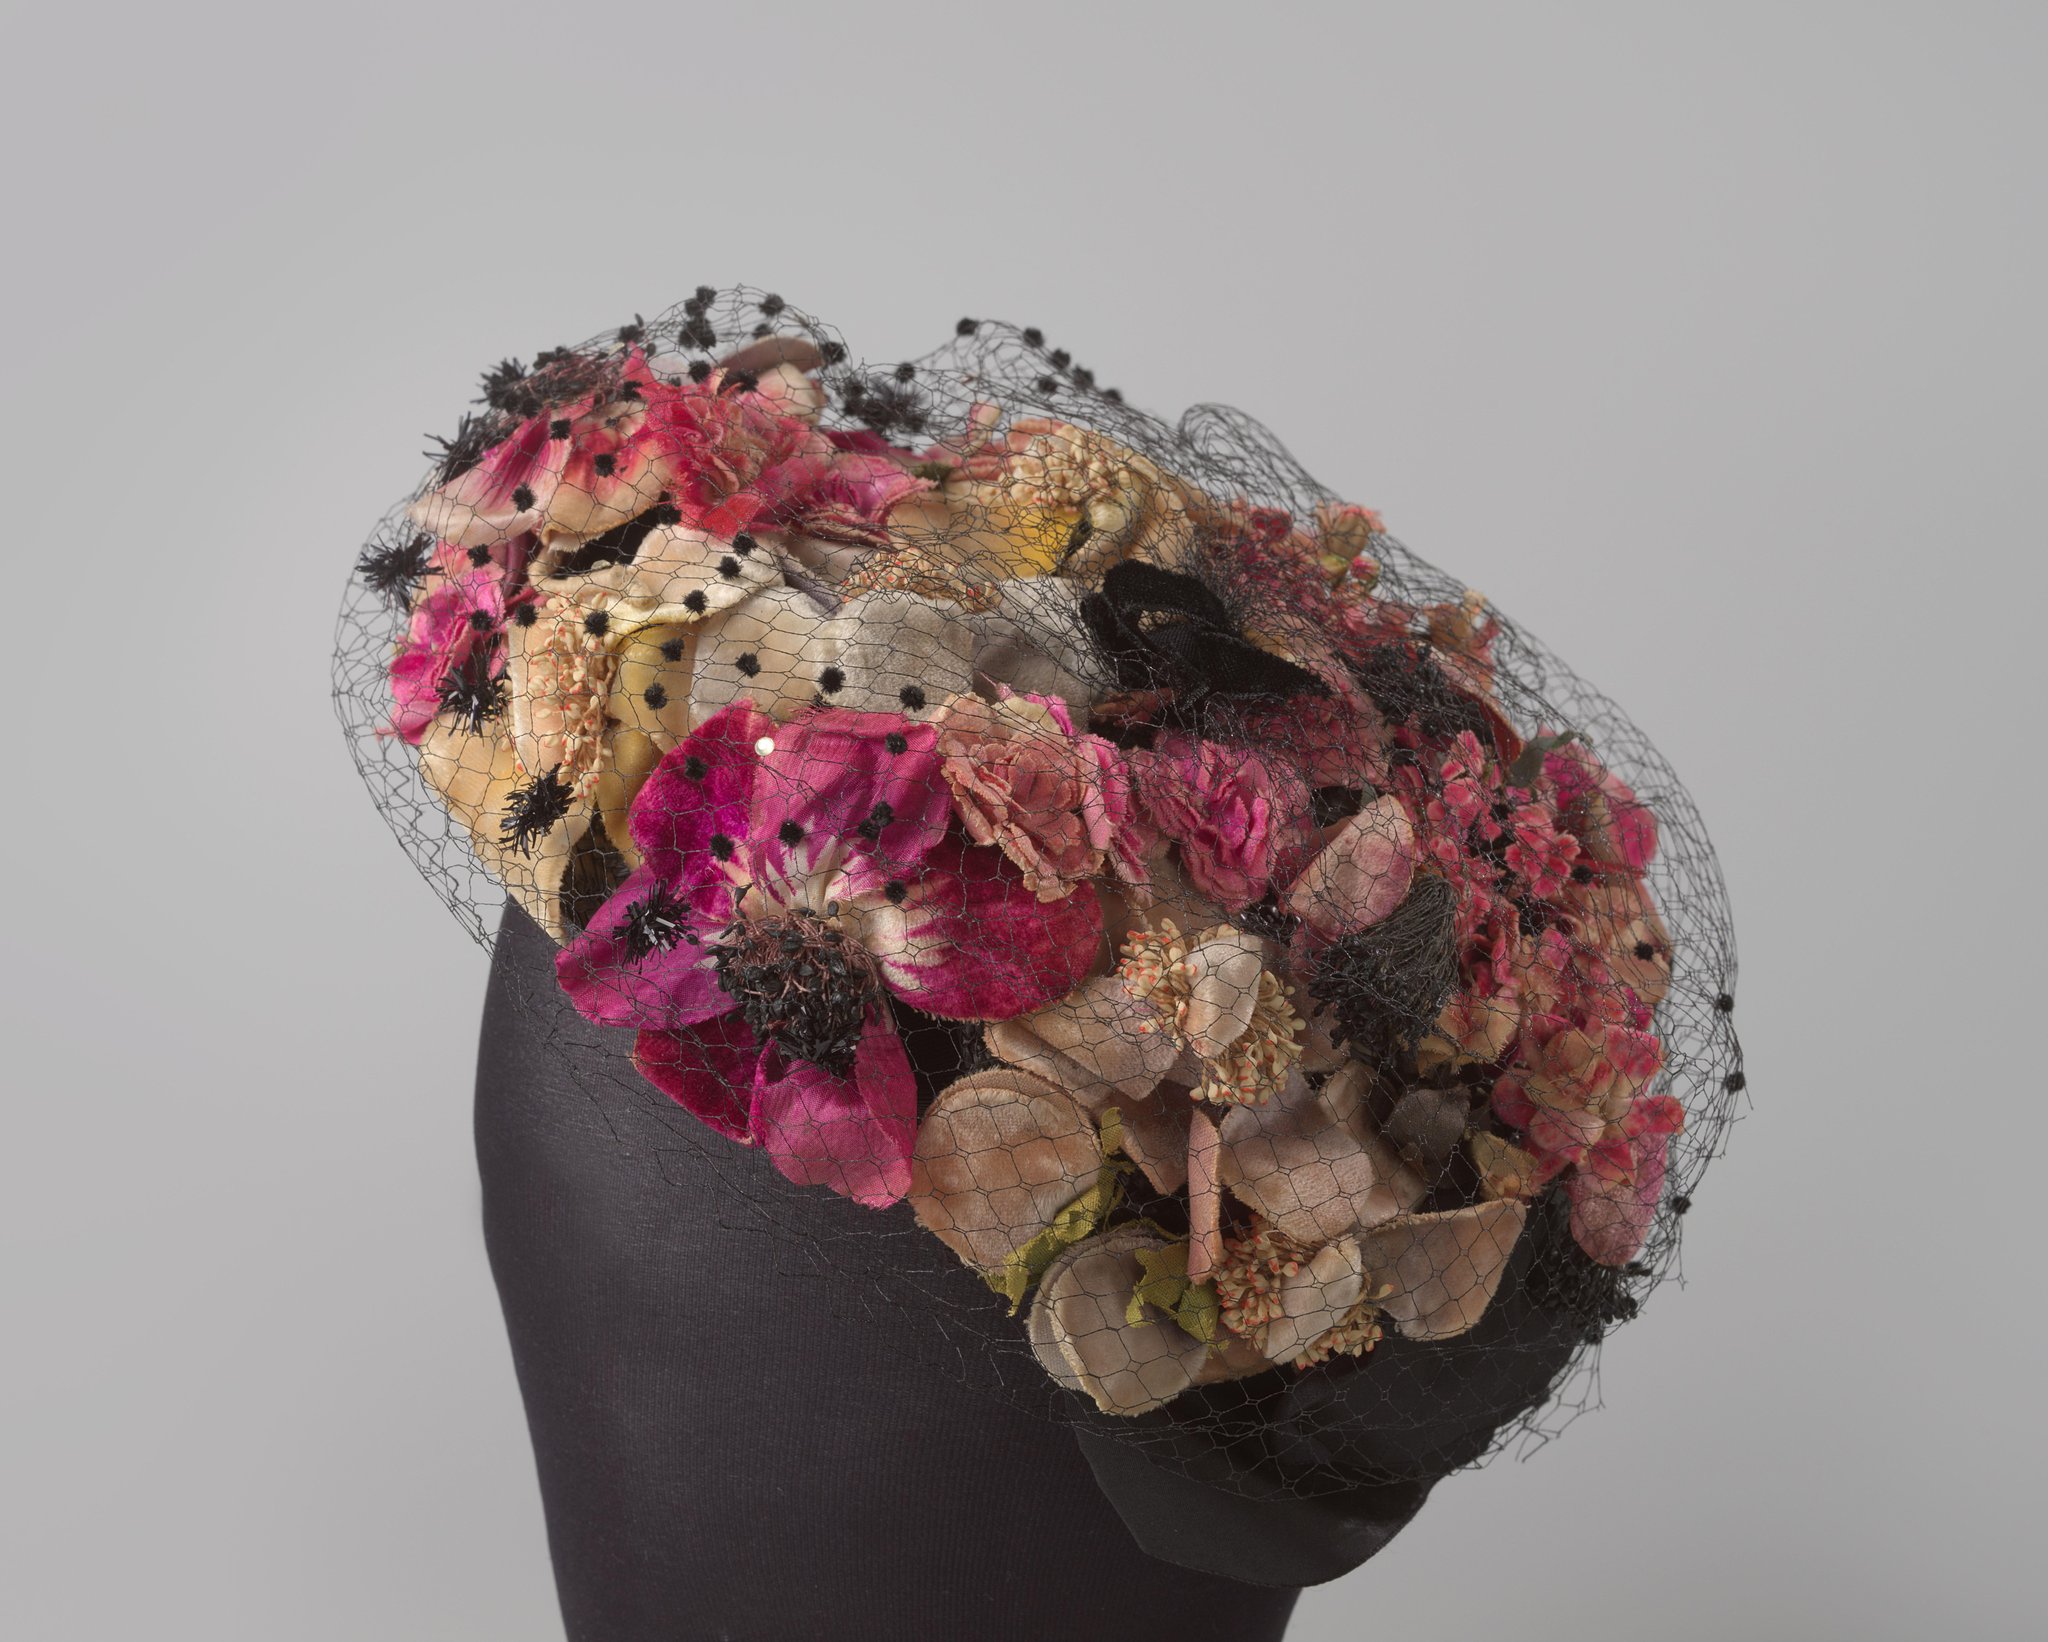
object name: womenswear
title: Hoed met zwarte strik in pillbox-model van zwart stro, geheel belegd met meerkleurige bloemen onder een afhangende zwarte voile met noppen en strasstenen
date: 1935-1940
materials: paste, velvet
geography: western europe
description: Hoed van grof zwart stro, geheel met bloemen belegd. Pillbox model, achter een zwarte strik. Rondom het staande deel loopt een krans van grote fluwelen bloemen, in lilarose, cerise, zachtgeel en violet. Op de bol kleine trosbloempjes in hardrose (later toegevoegd ?). Over het geheel een afhangende zwarte voile met nopjes en straszsteentjes. Binnenin staat op een etiketje: Wiener M ode.